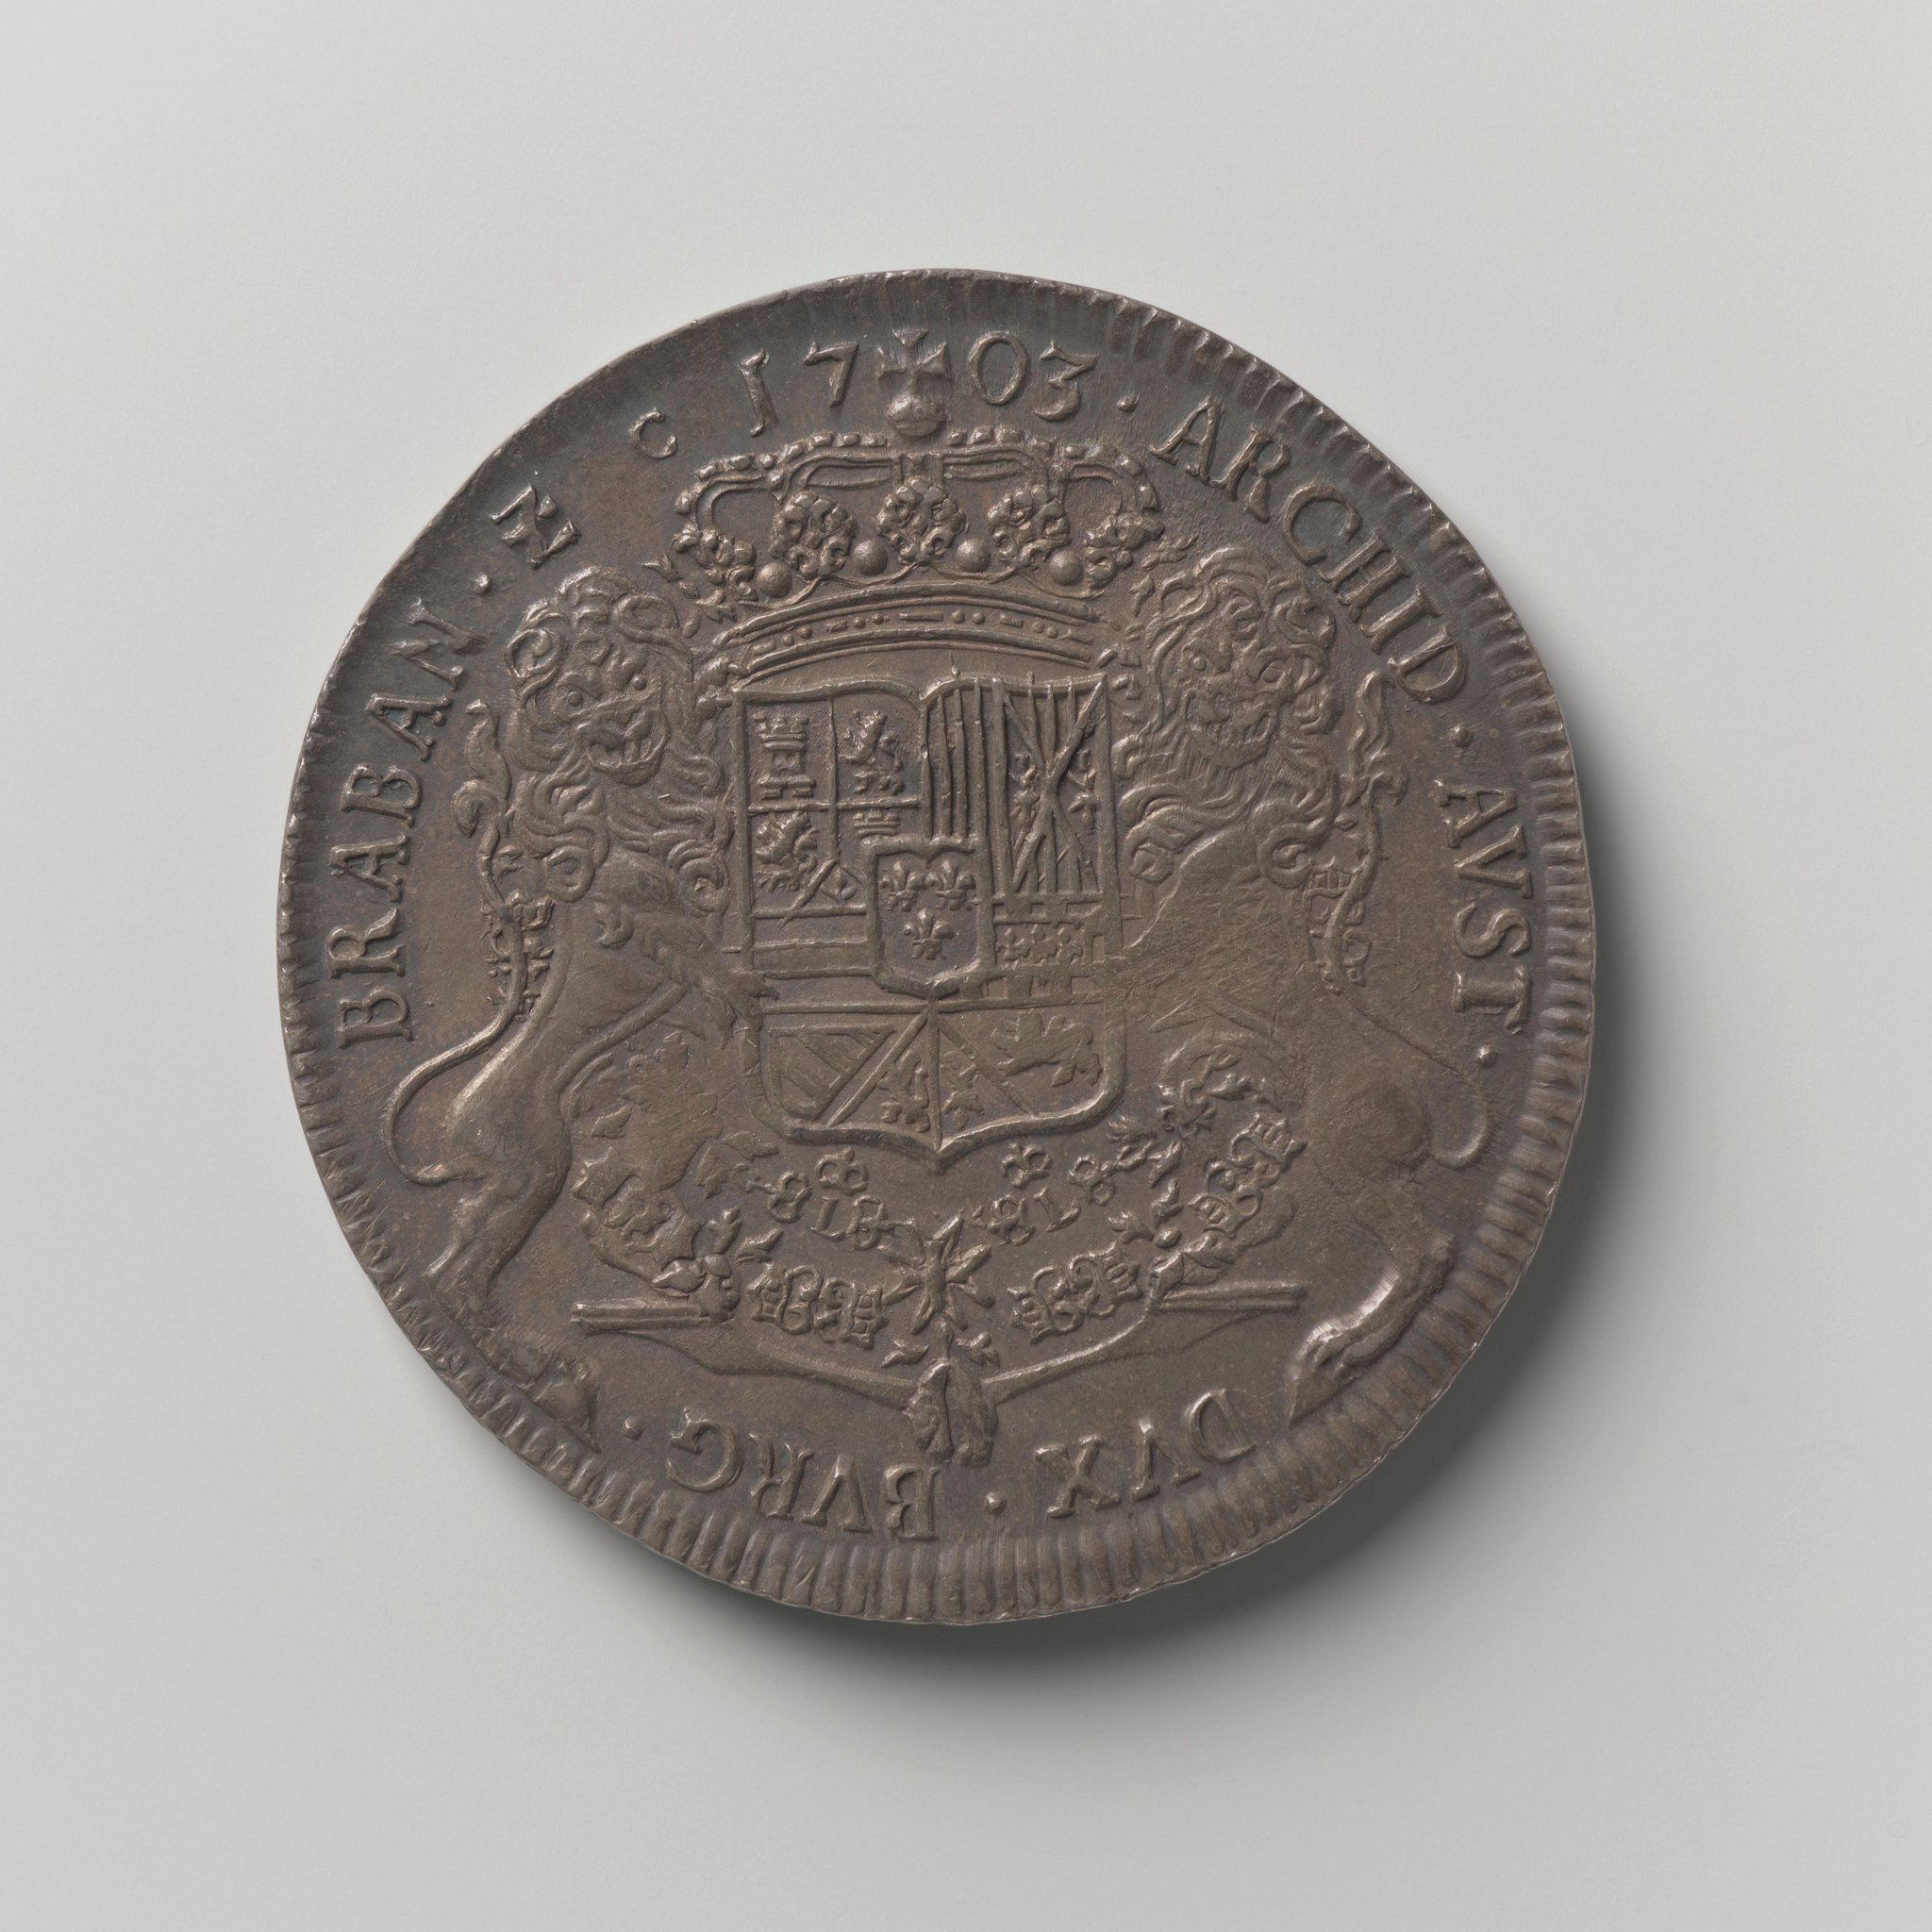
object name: ducatoon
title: Brabant, Philips V, dukaton, 1703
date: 1703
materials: silver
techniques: striking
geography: antwerp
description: Zilveren munt. Voorzijde: portret van Philips V met hoog reliëf naar rechts. Hand onder portret. Keerzijde: door twee leeuwen gehouden door keten van de heilige geest en keten van het gulden vlies omhangen gekroond samengesteld wapenschild. Jaartal rondom kroon. Kabelrand.